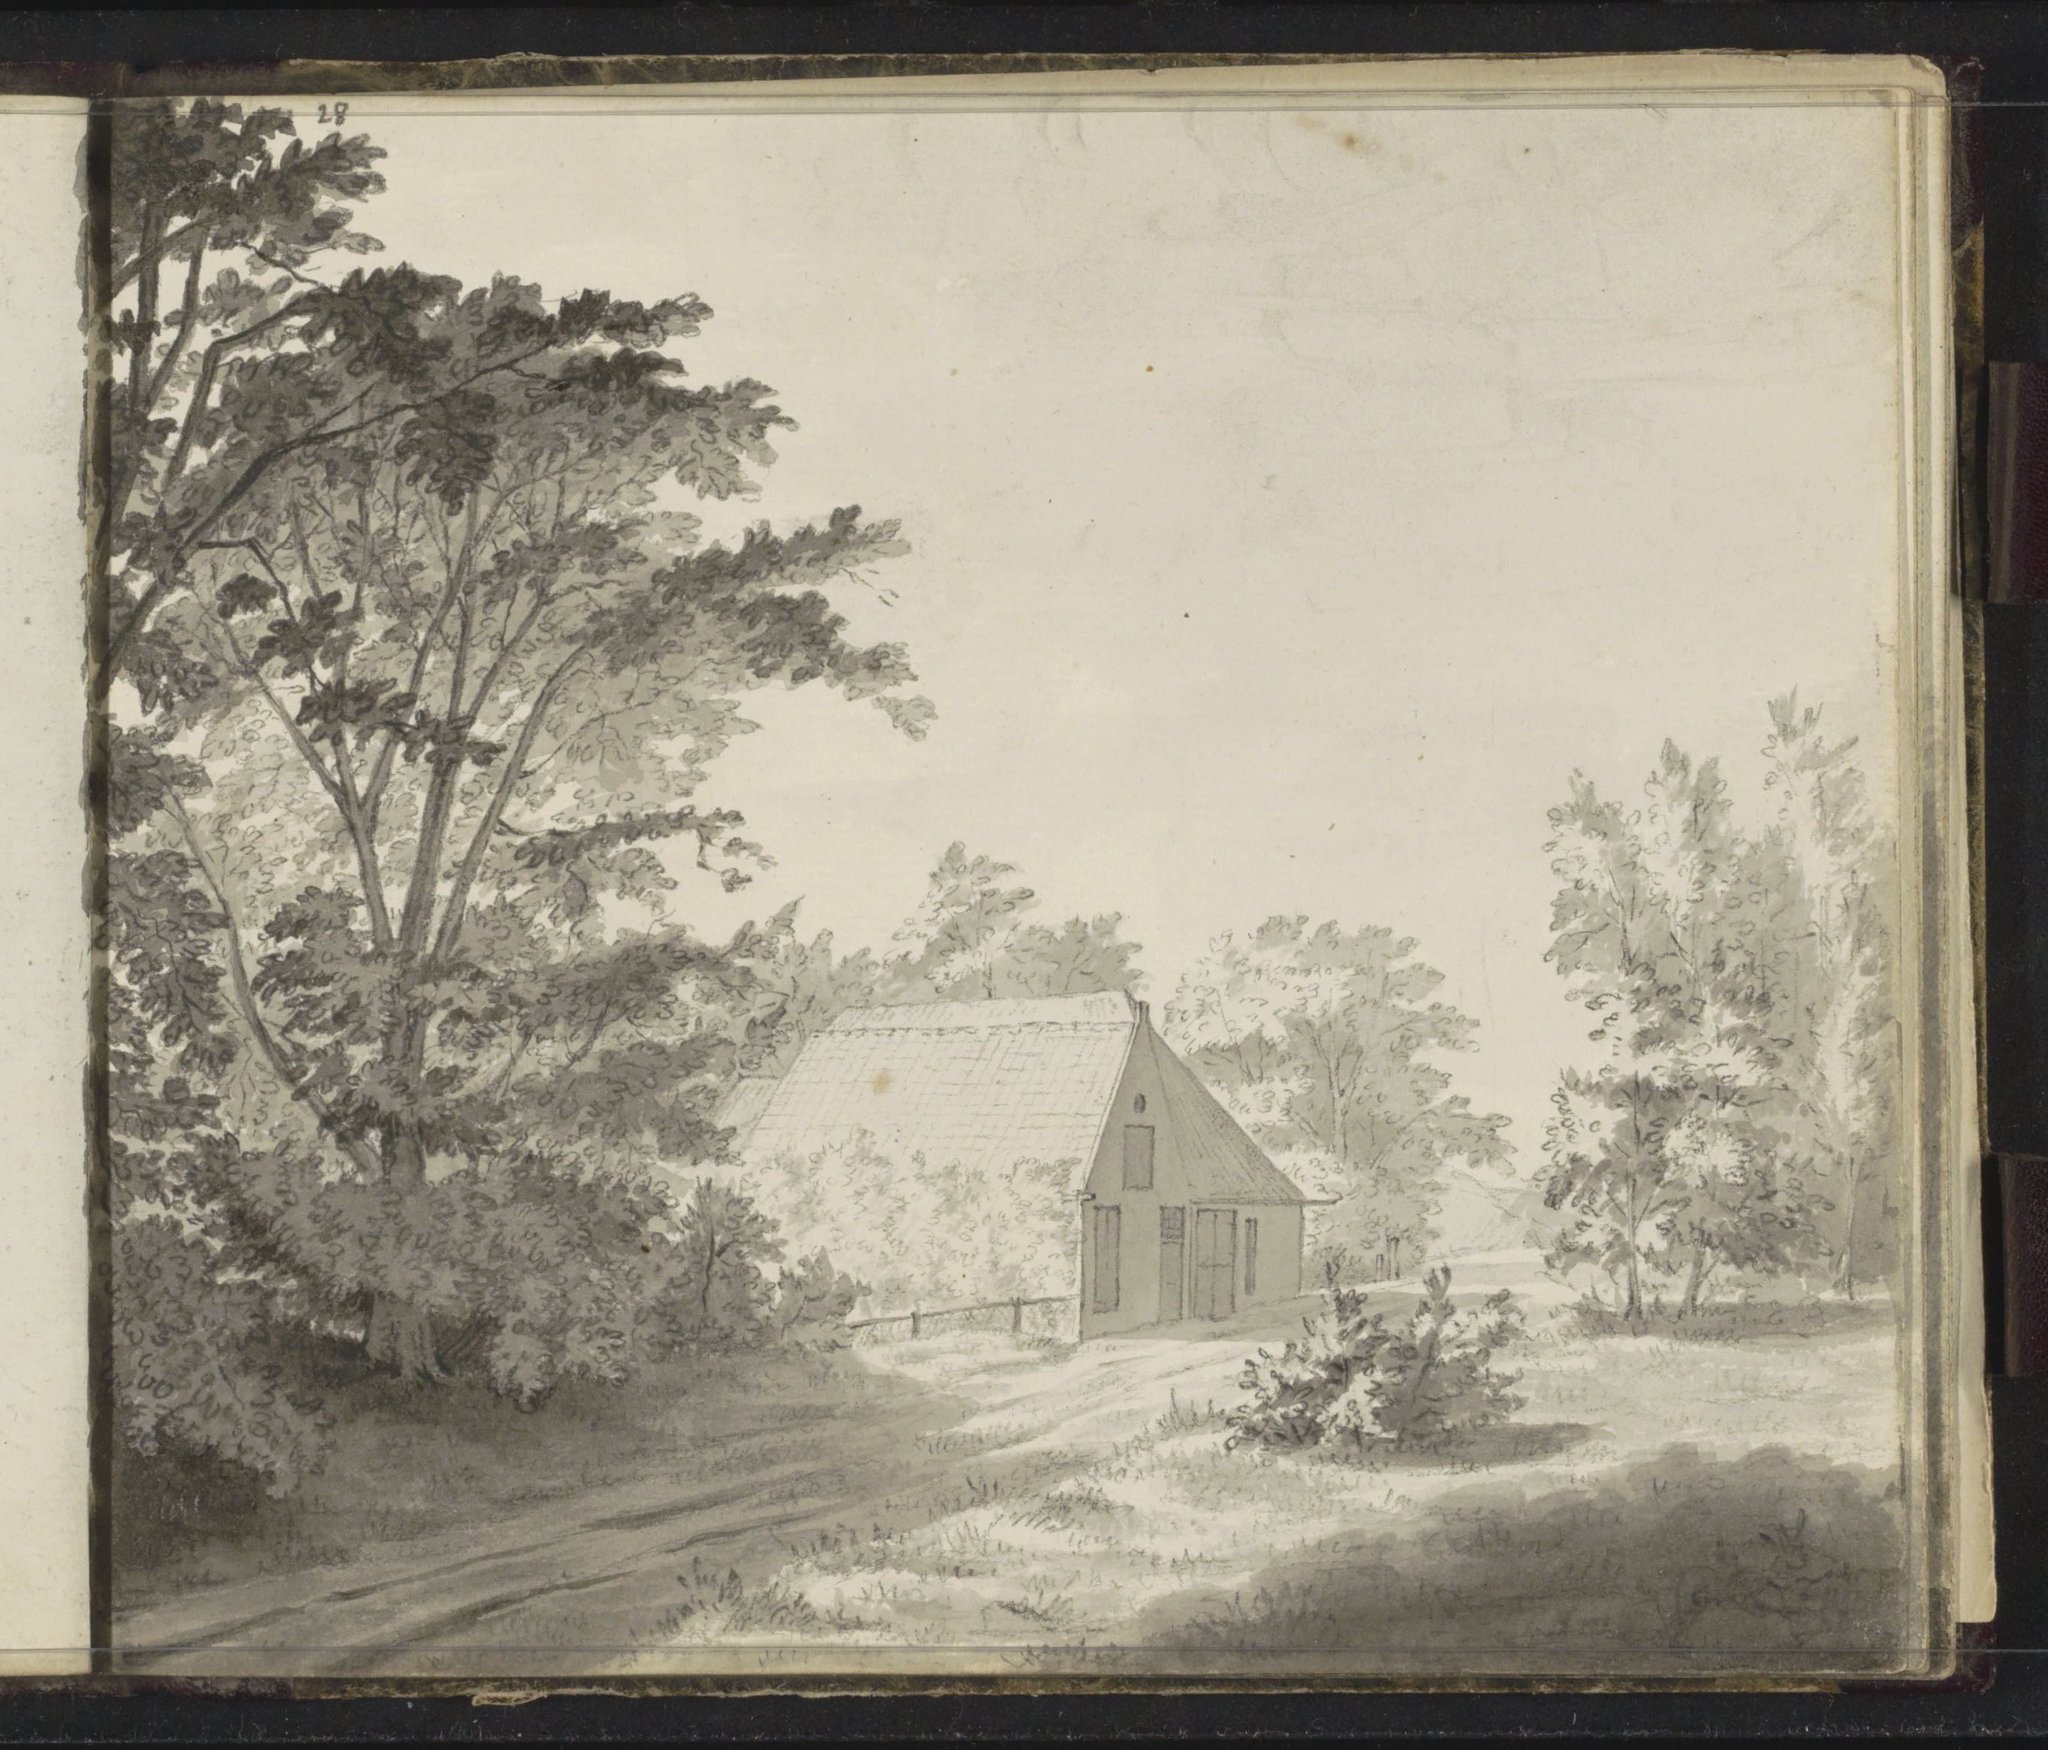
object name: sketchbook leaf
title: Huis aan een pad in een landschap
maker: hendrik abraham klinkhamer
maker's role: draughtsman, painter, print maker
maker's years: 1810-1872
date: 1820-1872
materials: chalk, paper, watercolor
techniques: brush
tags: fence, wall, paling, farm or solitary house in landscape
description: Blad 28 recto uit een schetsboek met 39 bladen.